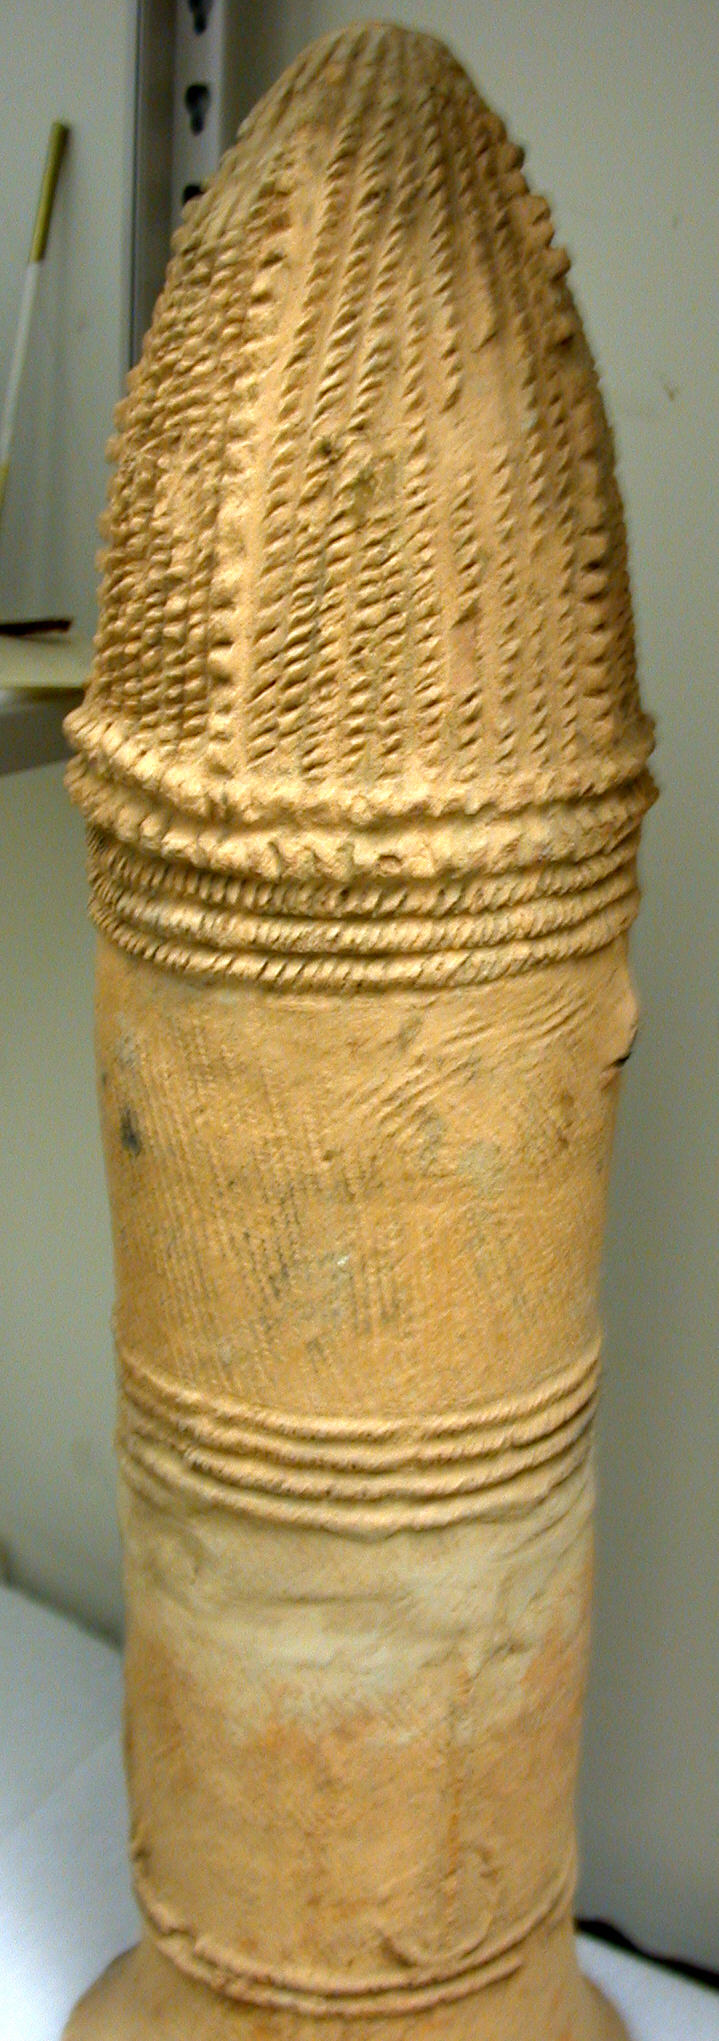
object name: grave marker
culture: bura peoples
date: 201-1100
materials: terracotta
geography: niger